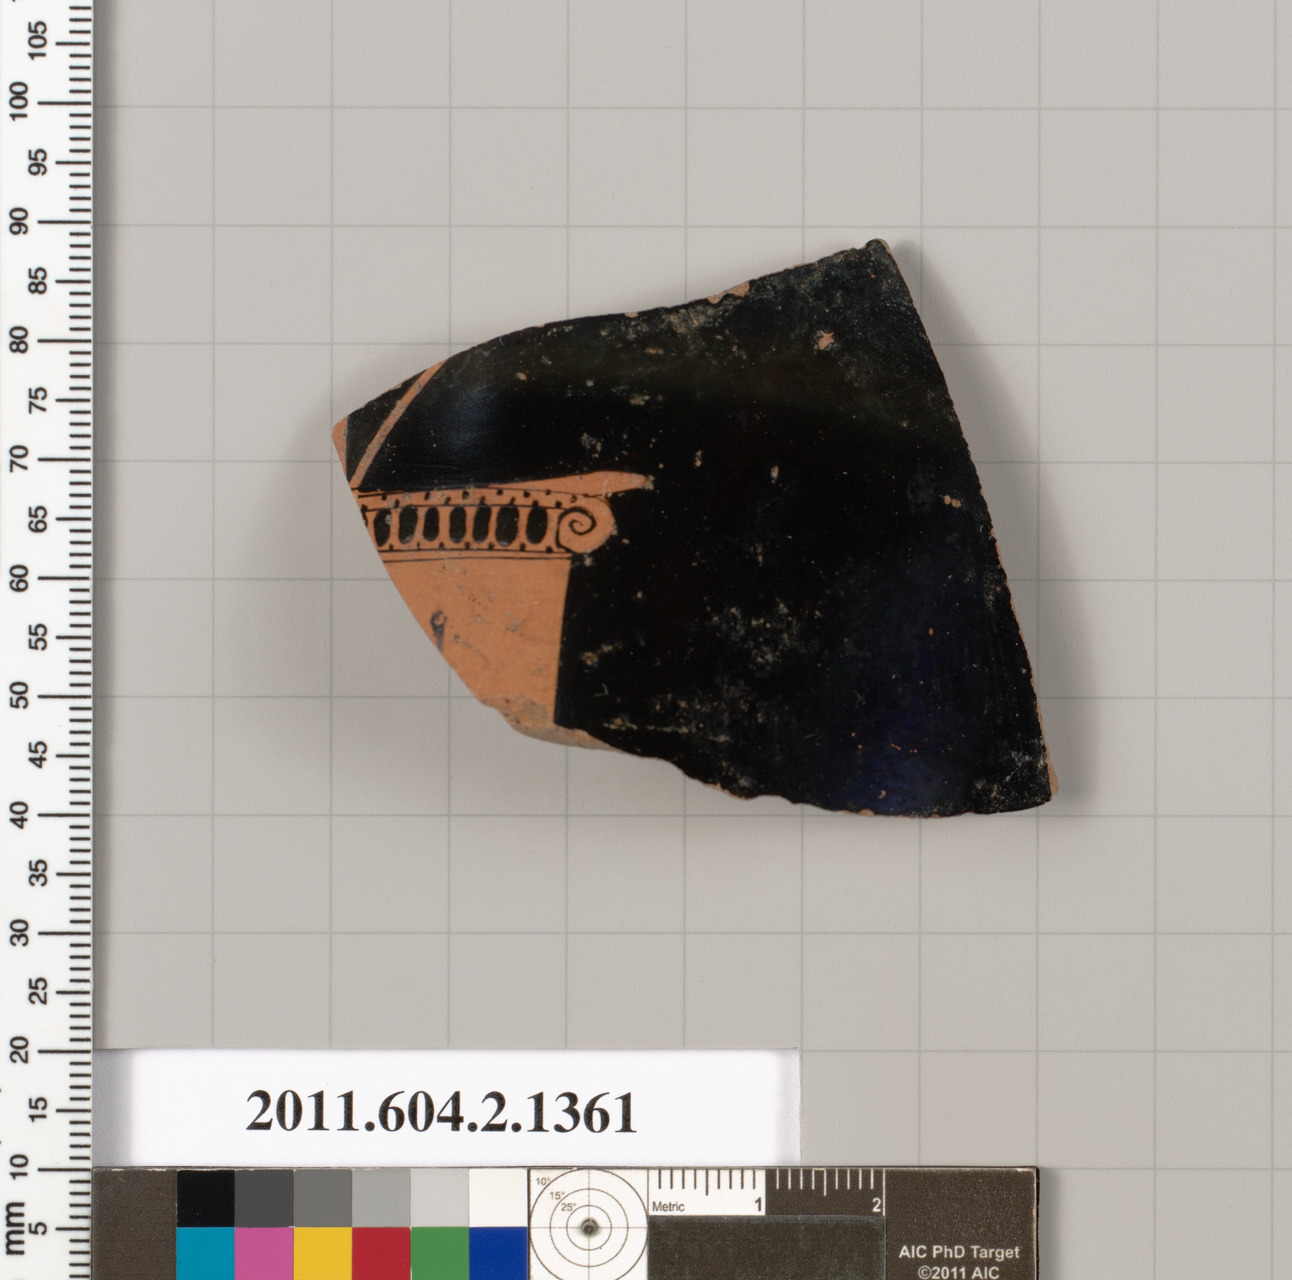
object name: skyphos fragment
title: Terracotta fragment of a skyphos (deep drinking cup)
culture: greek, attic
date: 470-460 BCE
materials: terracotta